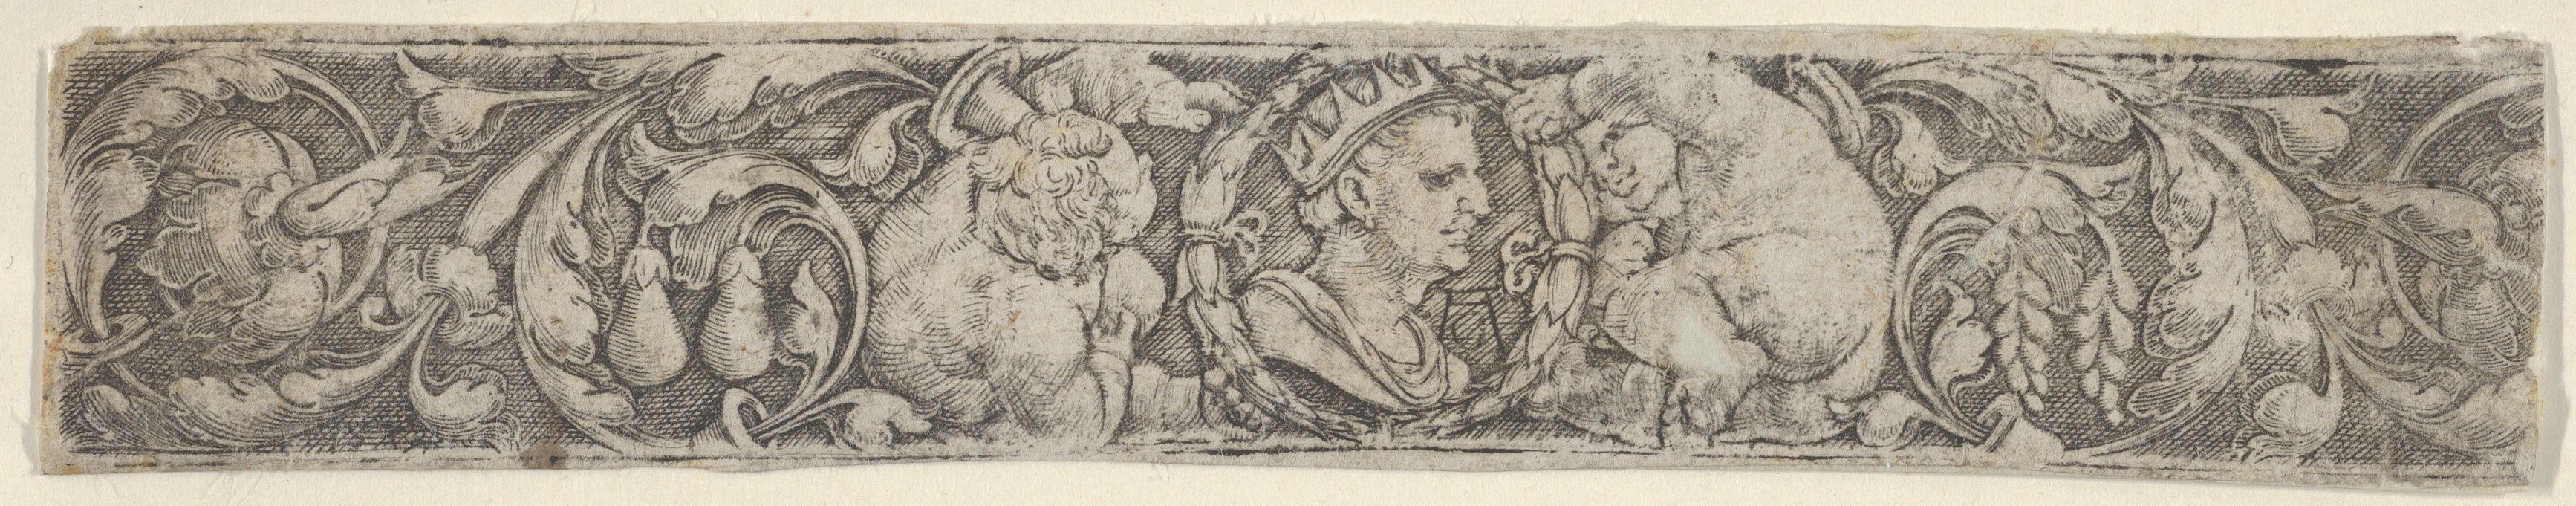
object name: print ornament architecture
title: Frieze with Children Supporting the Bust of an Emperor Surrounded by Foliate Scrolls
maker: heinrich aldegrever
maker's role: artist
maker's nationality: german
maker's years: 1502-1561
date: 1539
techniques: engraving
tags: men,putti